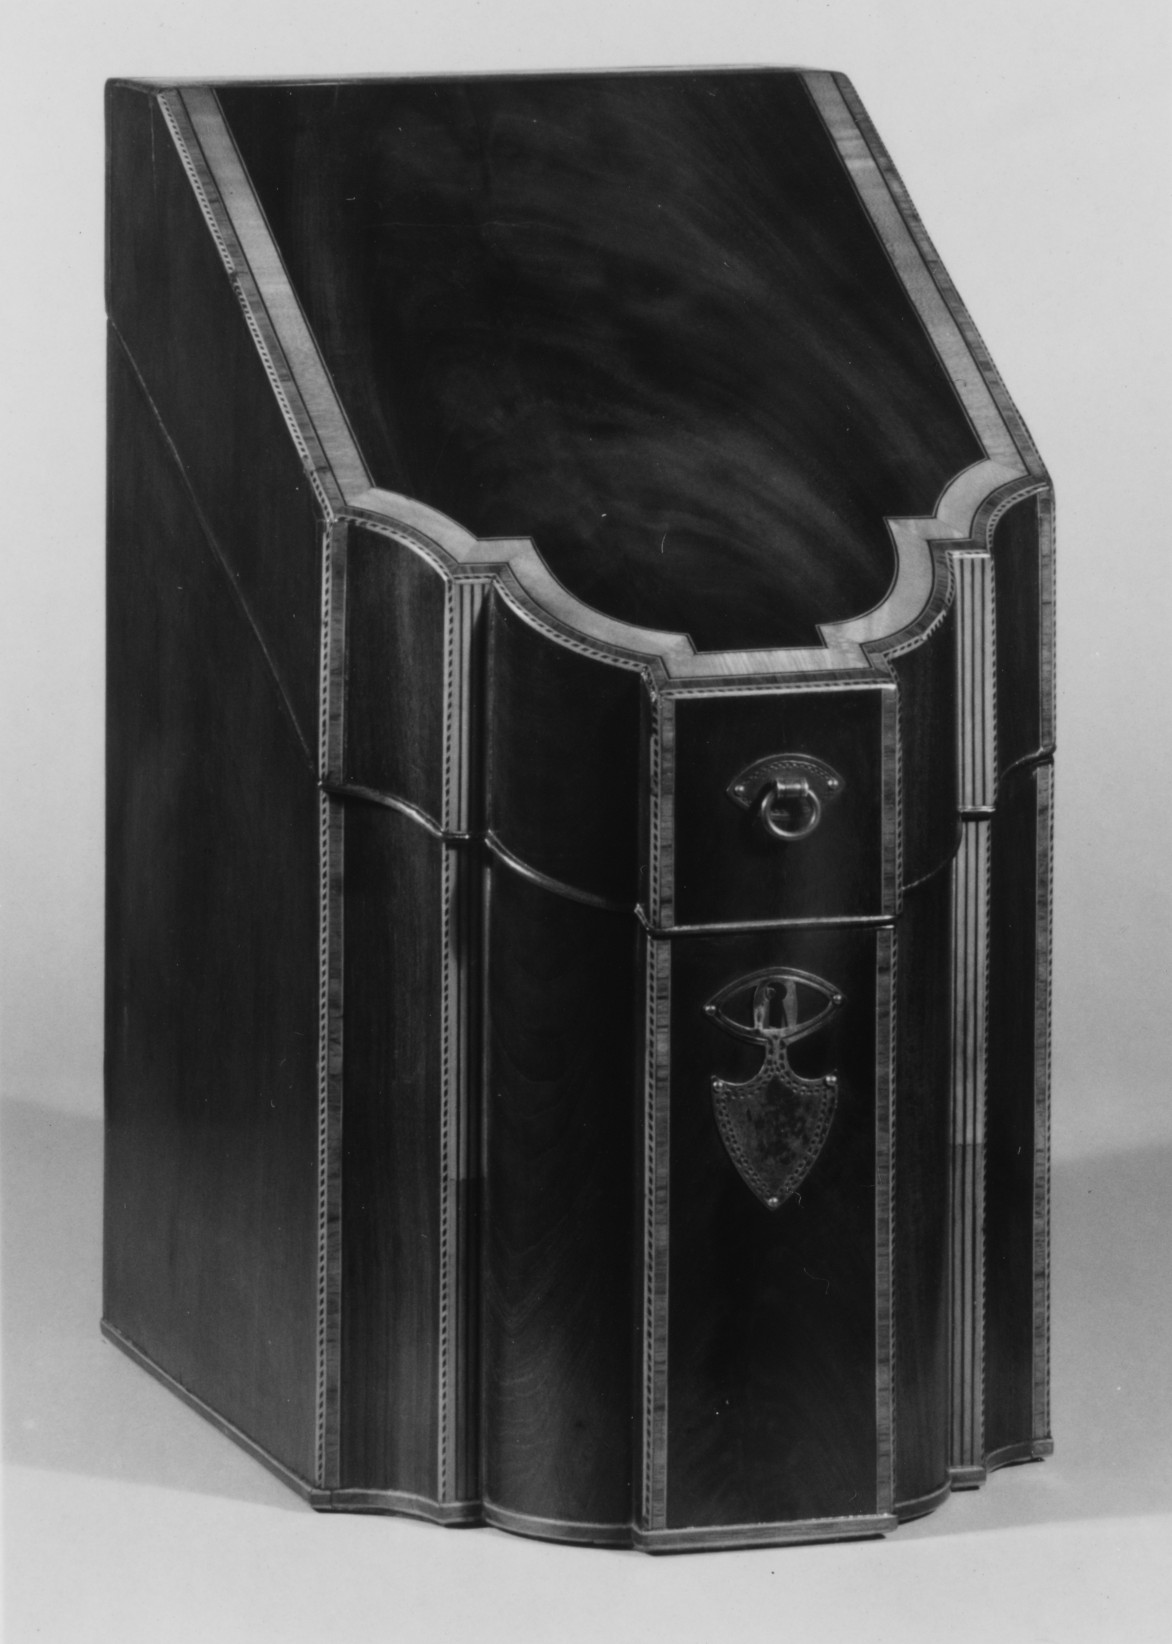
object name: knife box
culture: american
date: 1790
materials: wood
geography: united states